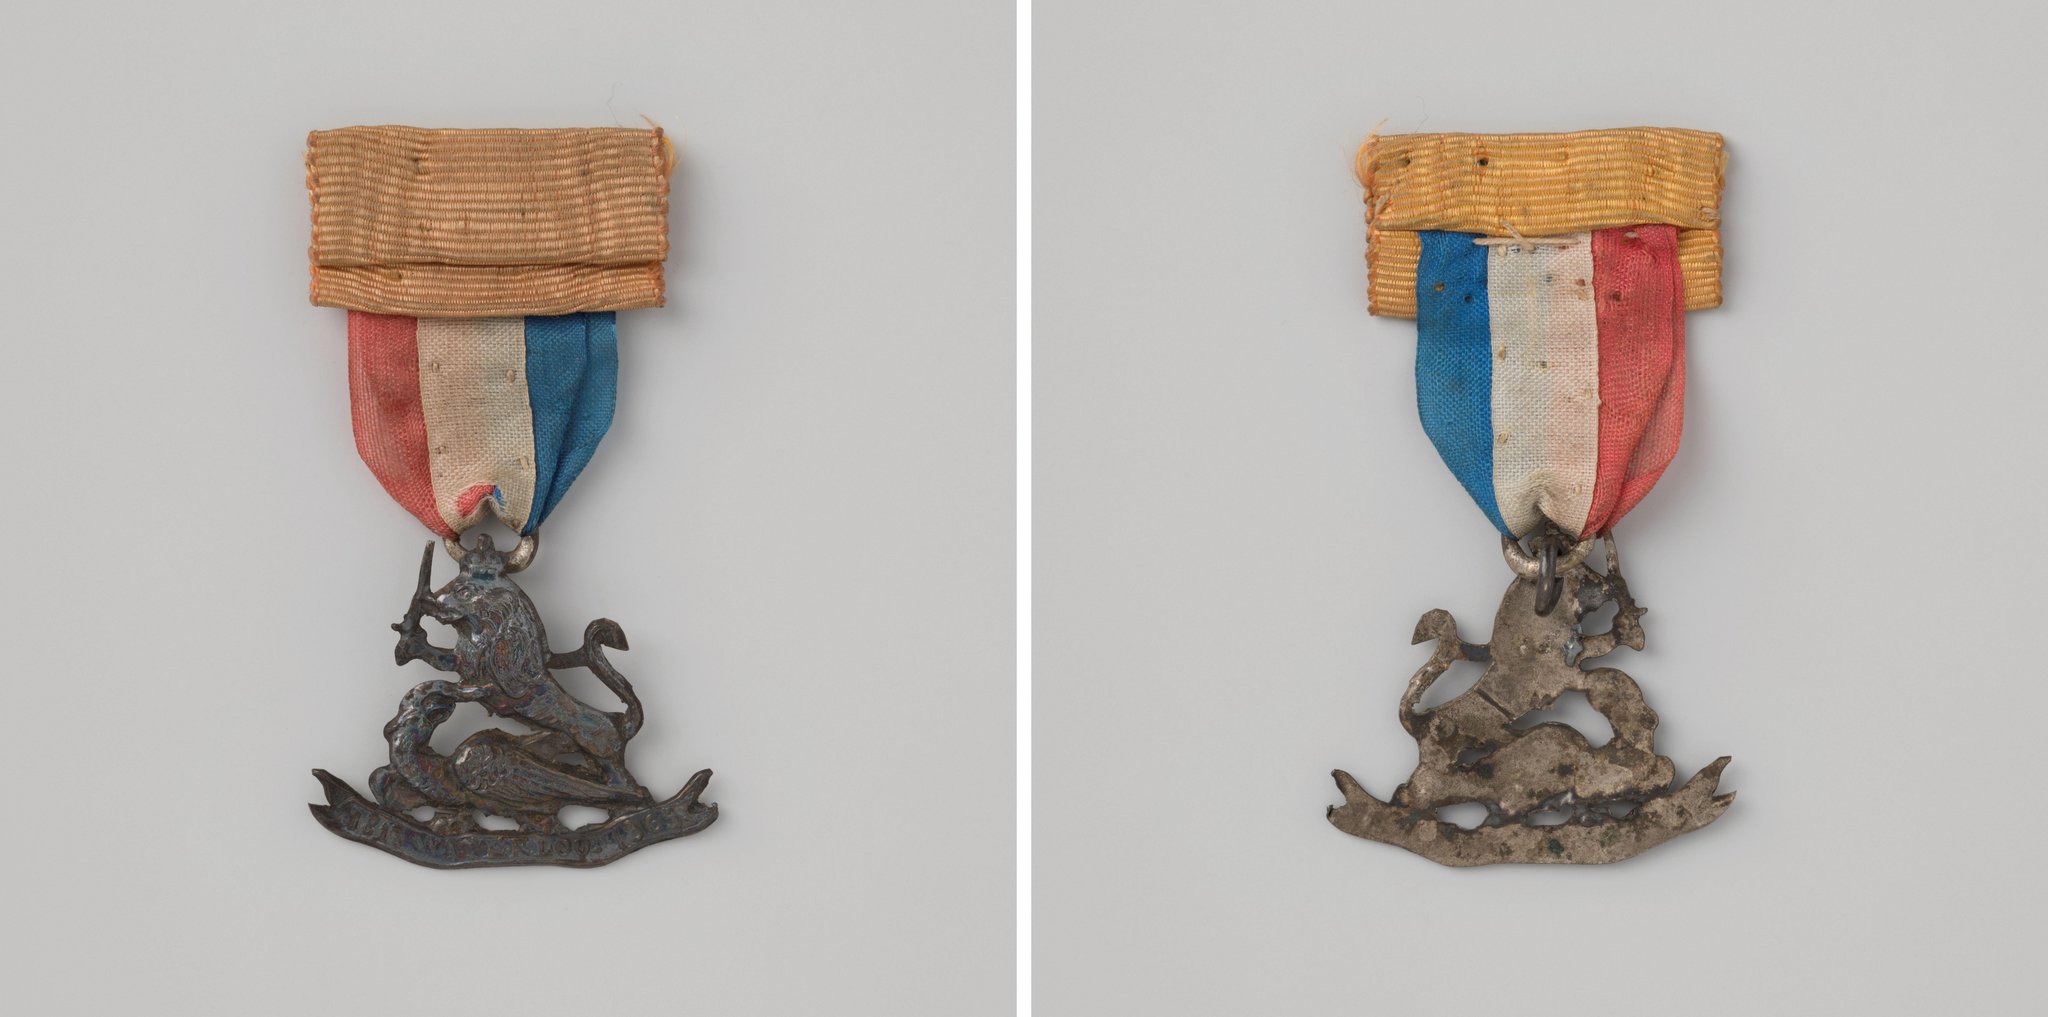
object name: insignia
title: Vijftigjarige herdenking van de Slag bij Waterloo gevierd in Leiden 1865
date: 1865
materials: silver, textile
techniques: pressing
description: Verzilverd draagteken in de vorm van een Nederlandse leeuw die de Franse adelaar verslaat op een banderol met de tekst 1815 WATERLOO 1865, met draagoog en ring, aan een rood wit blauw lint aan oranje strik